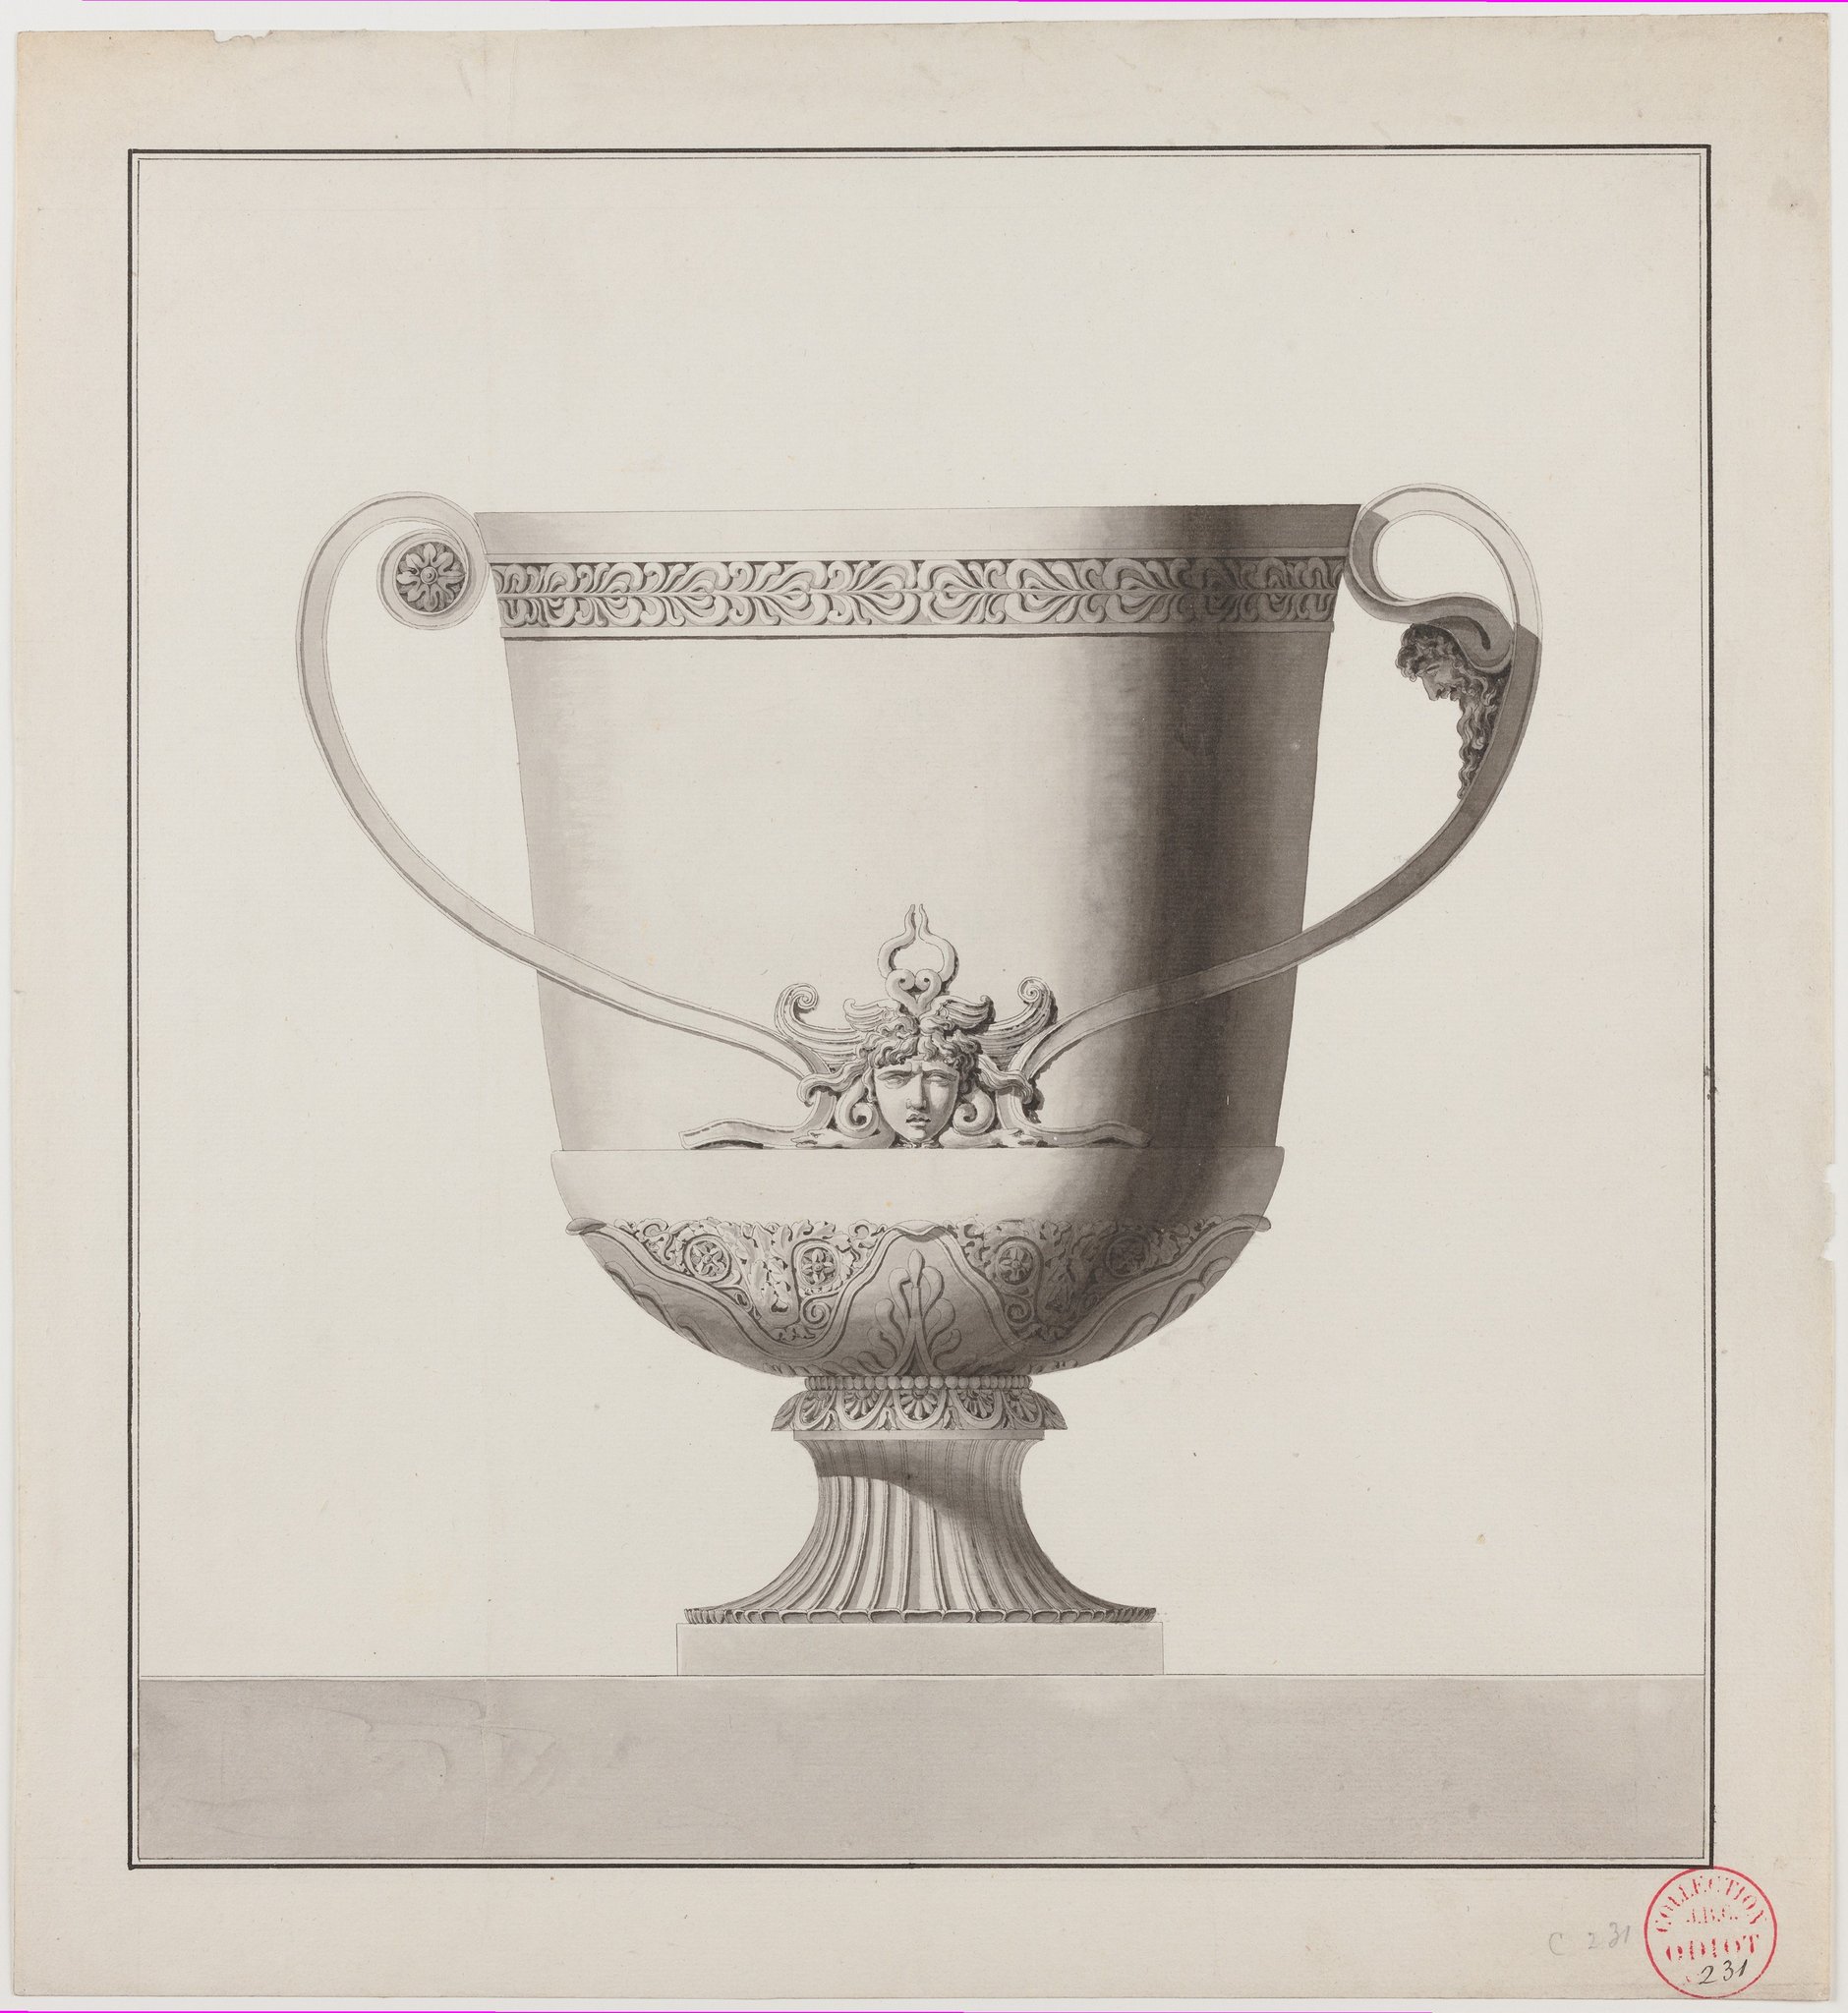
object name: drawing collection ornament architecture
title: Design for a Wine Cooler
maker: henri auguste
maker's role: artist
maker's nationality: french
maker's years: 1759-1816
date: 1770-1800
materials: ink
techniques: brush, pen, wash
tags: vessels